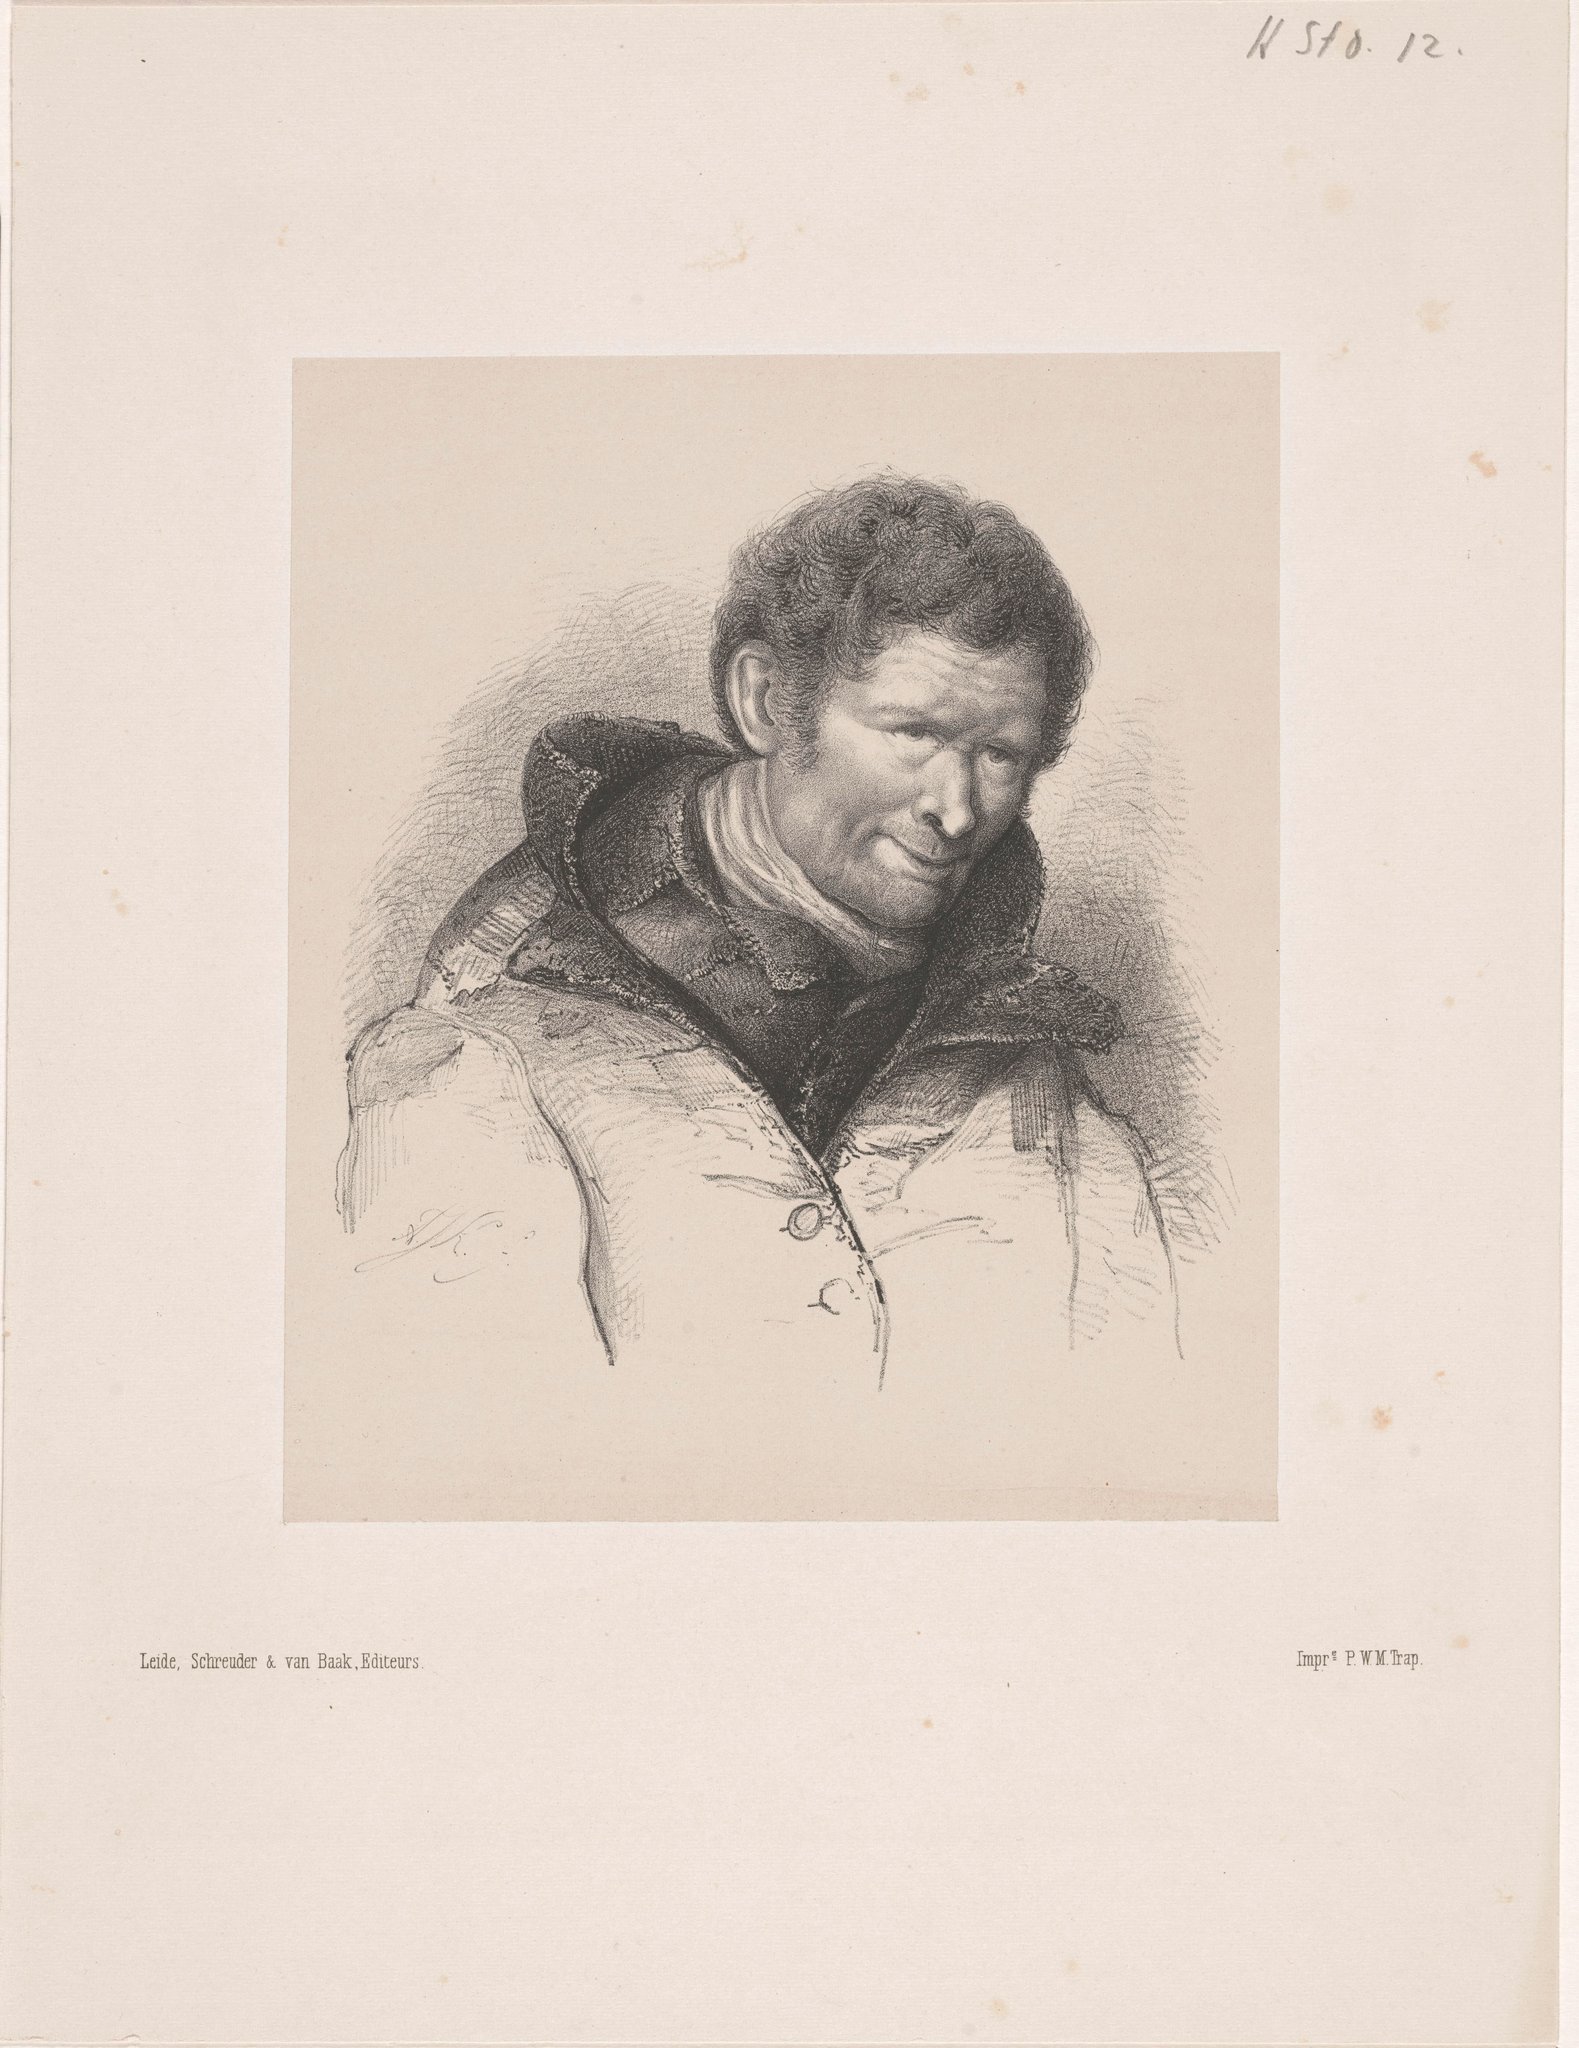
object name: print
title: Man in oude kapotte jas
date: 1834-1888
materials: paper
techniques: lithograph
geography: leiden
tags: clothed in rags, anonymous historical person portrayed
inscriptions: collector's mark: Lugt 2228, collector's mark: Lugt 2760